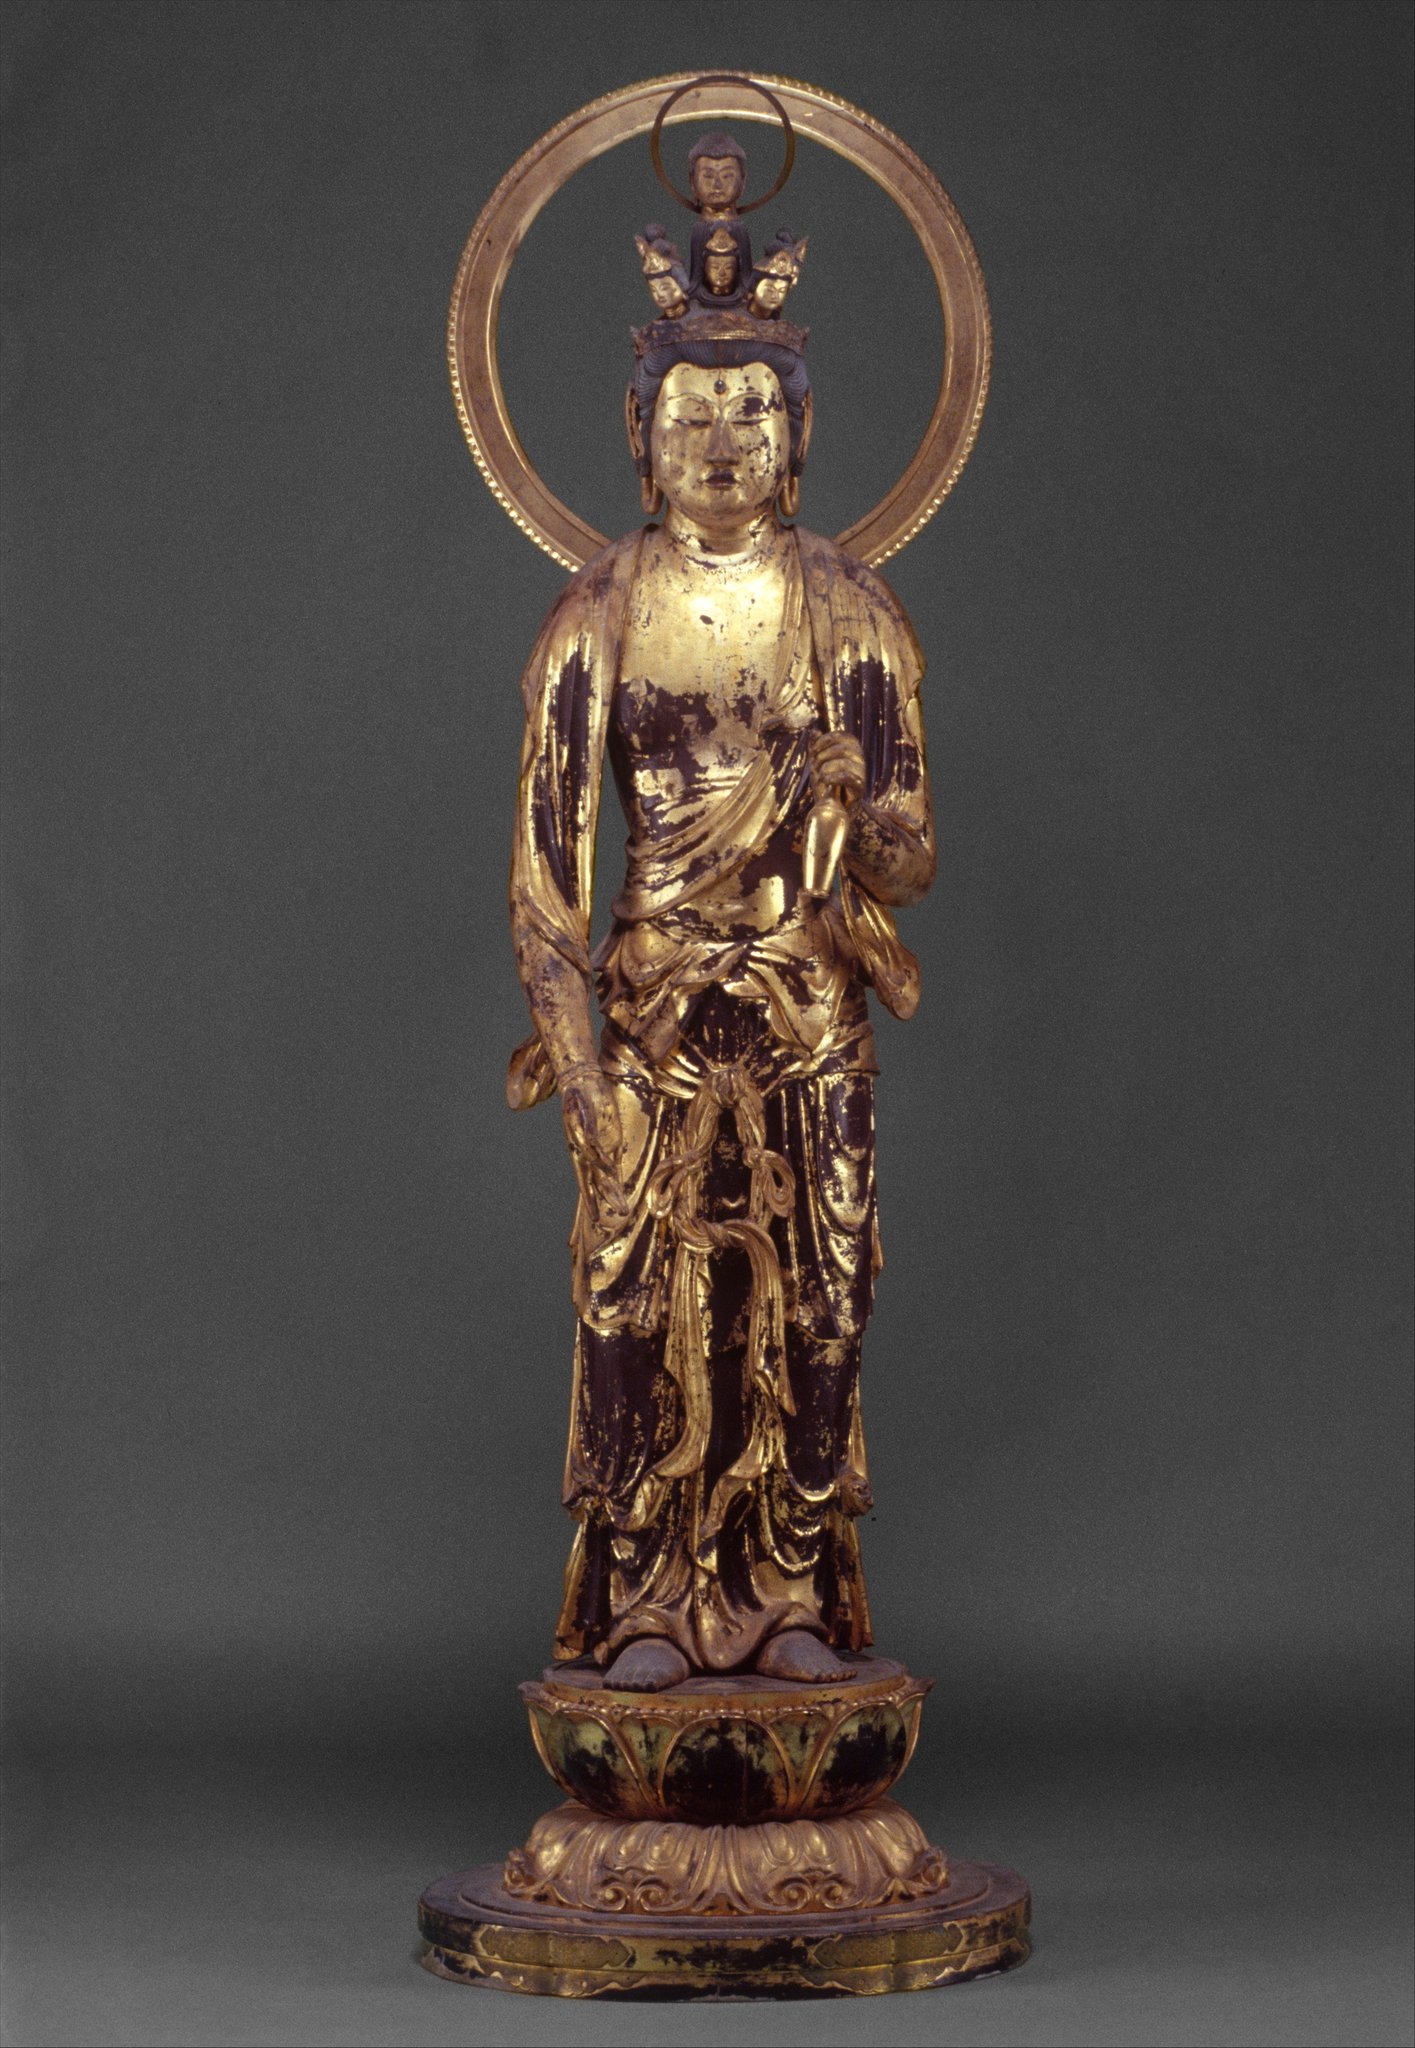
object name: statue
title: Jūichimen Kannon, the Bodhisattva of Compassion with Eleven Heads (Avalokiteshvara)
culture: japanese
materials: gold leaf, lacquer, metal, wood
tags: buddhism,avalokiteshvara,bodhisattvas